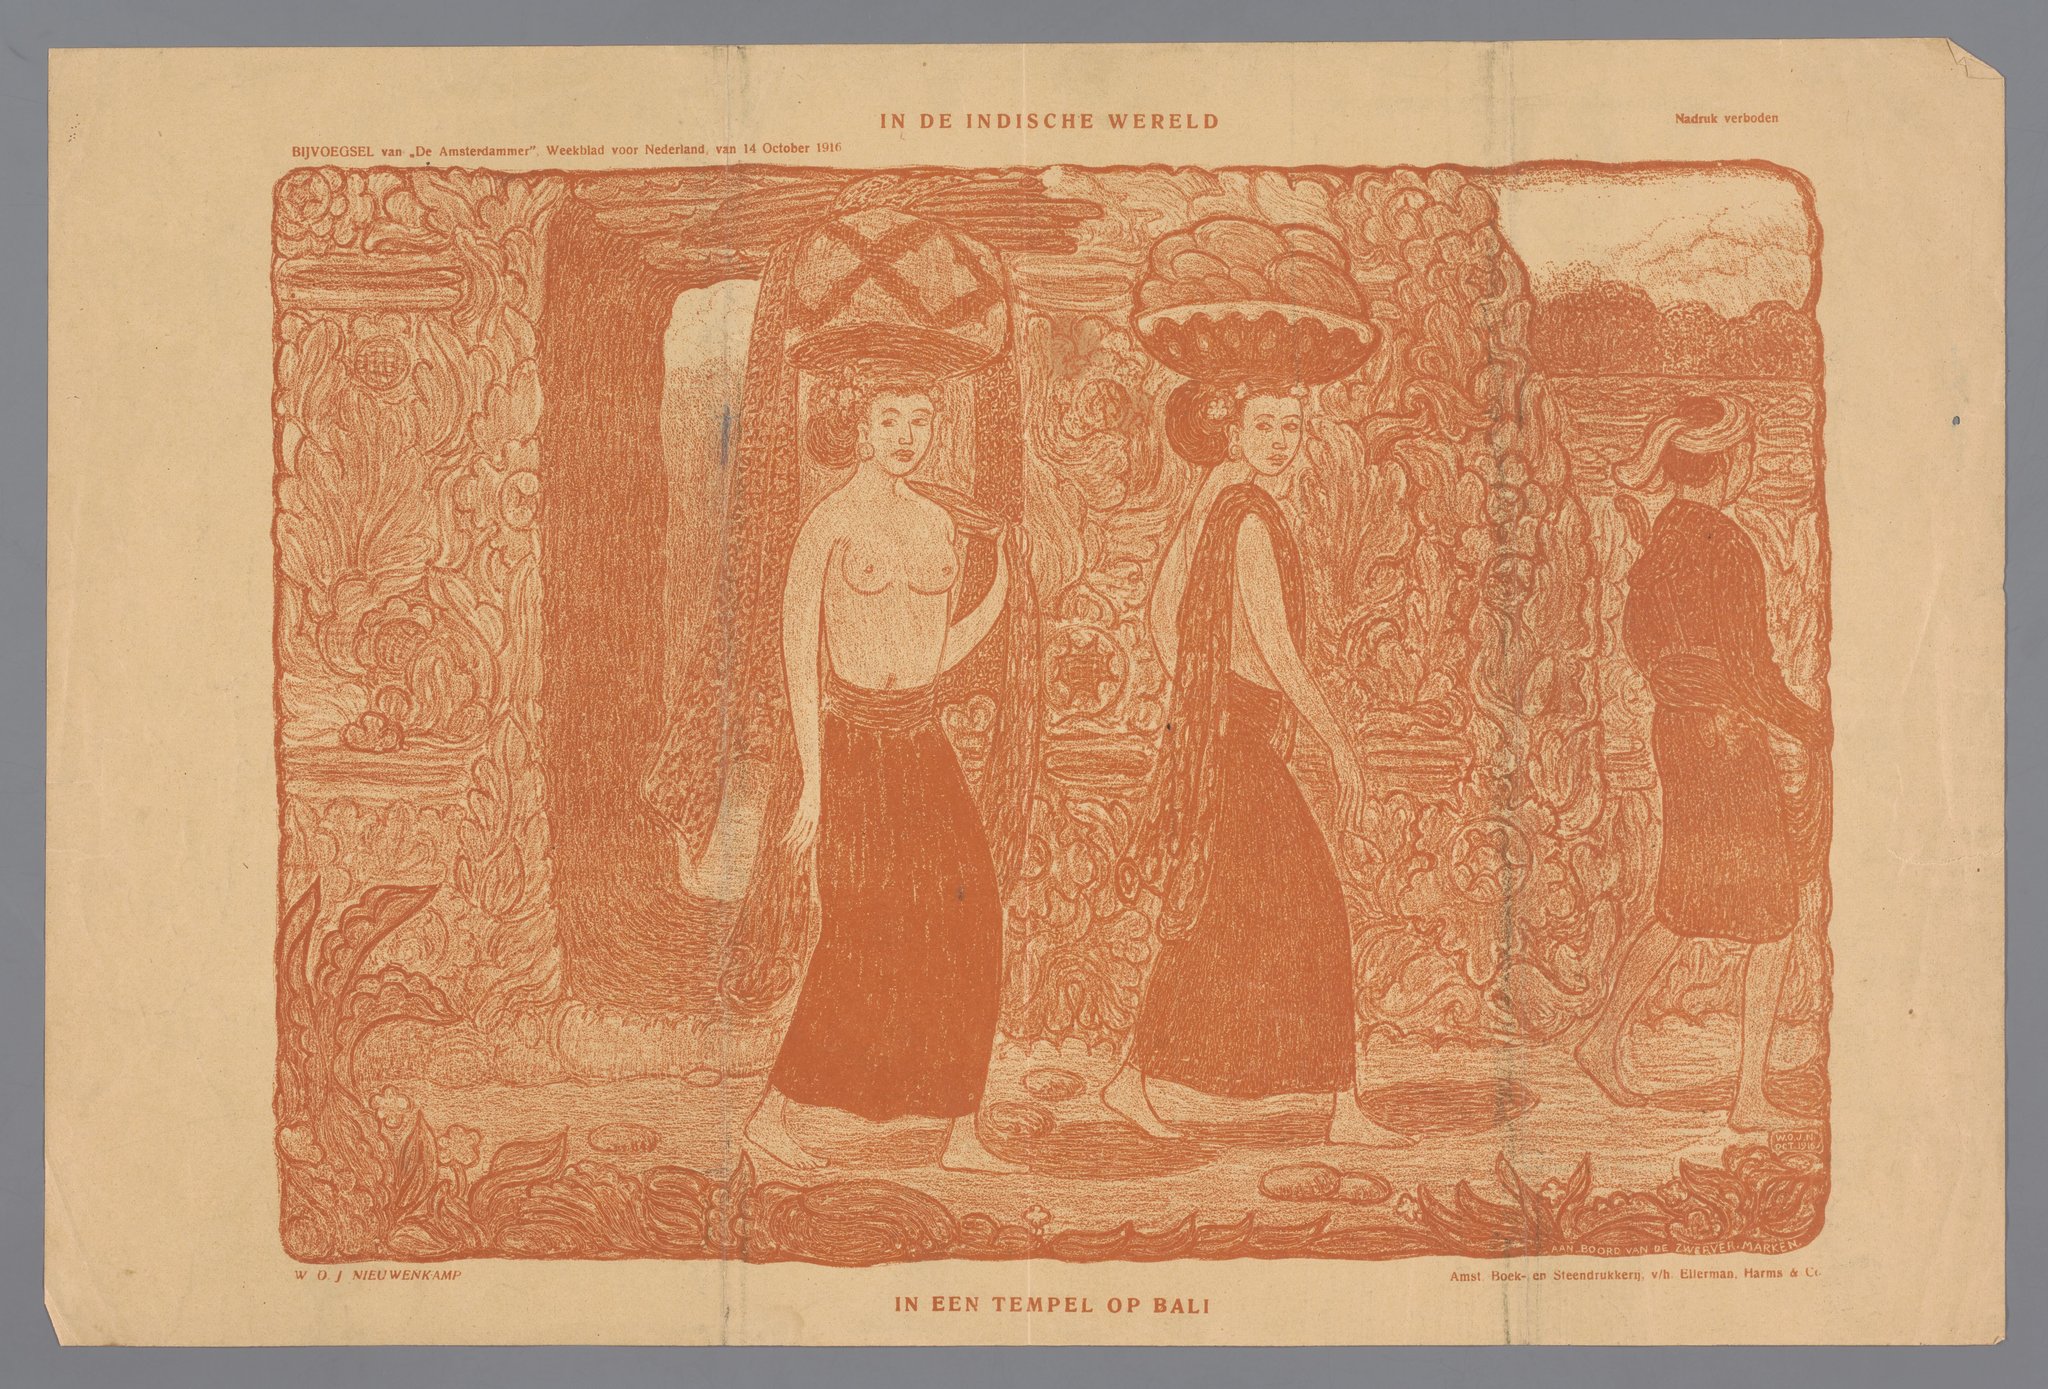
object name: print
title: In de Indische Wereld / In een tempel op Bali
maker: wijnand otto jan nieuwenkamp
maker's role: draughtsman, print maker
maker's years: 1874-1950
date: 1916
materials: paper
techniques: lithograph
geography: amsterdam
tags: asiatic races and peoples (indonesians), carrying something on the head or on the shoulders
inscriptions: date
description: Prent met titel en onderschrift, bijvoegsel bij 'De Amsterdammer'. Gesigneerd en gedateerd.